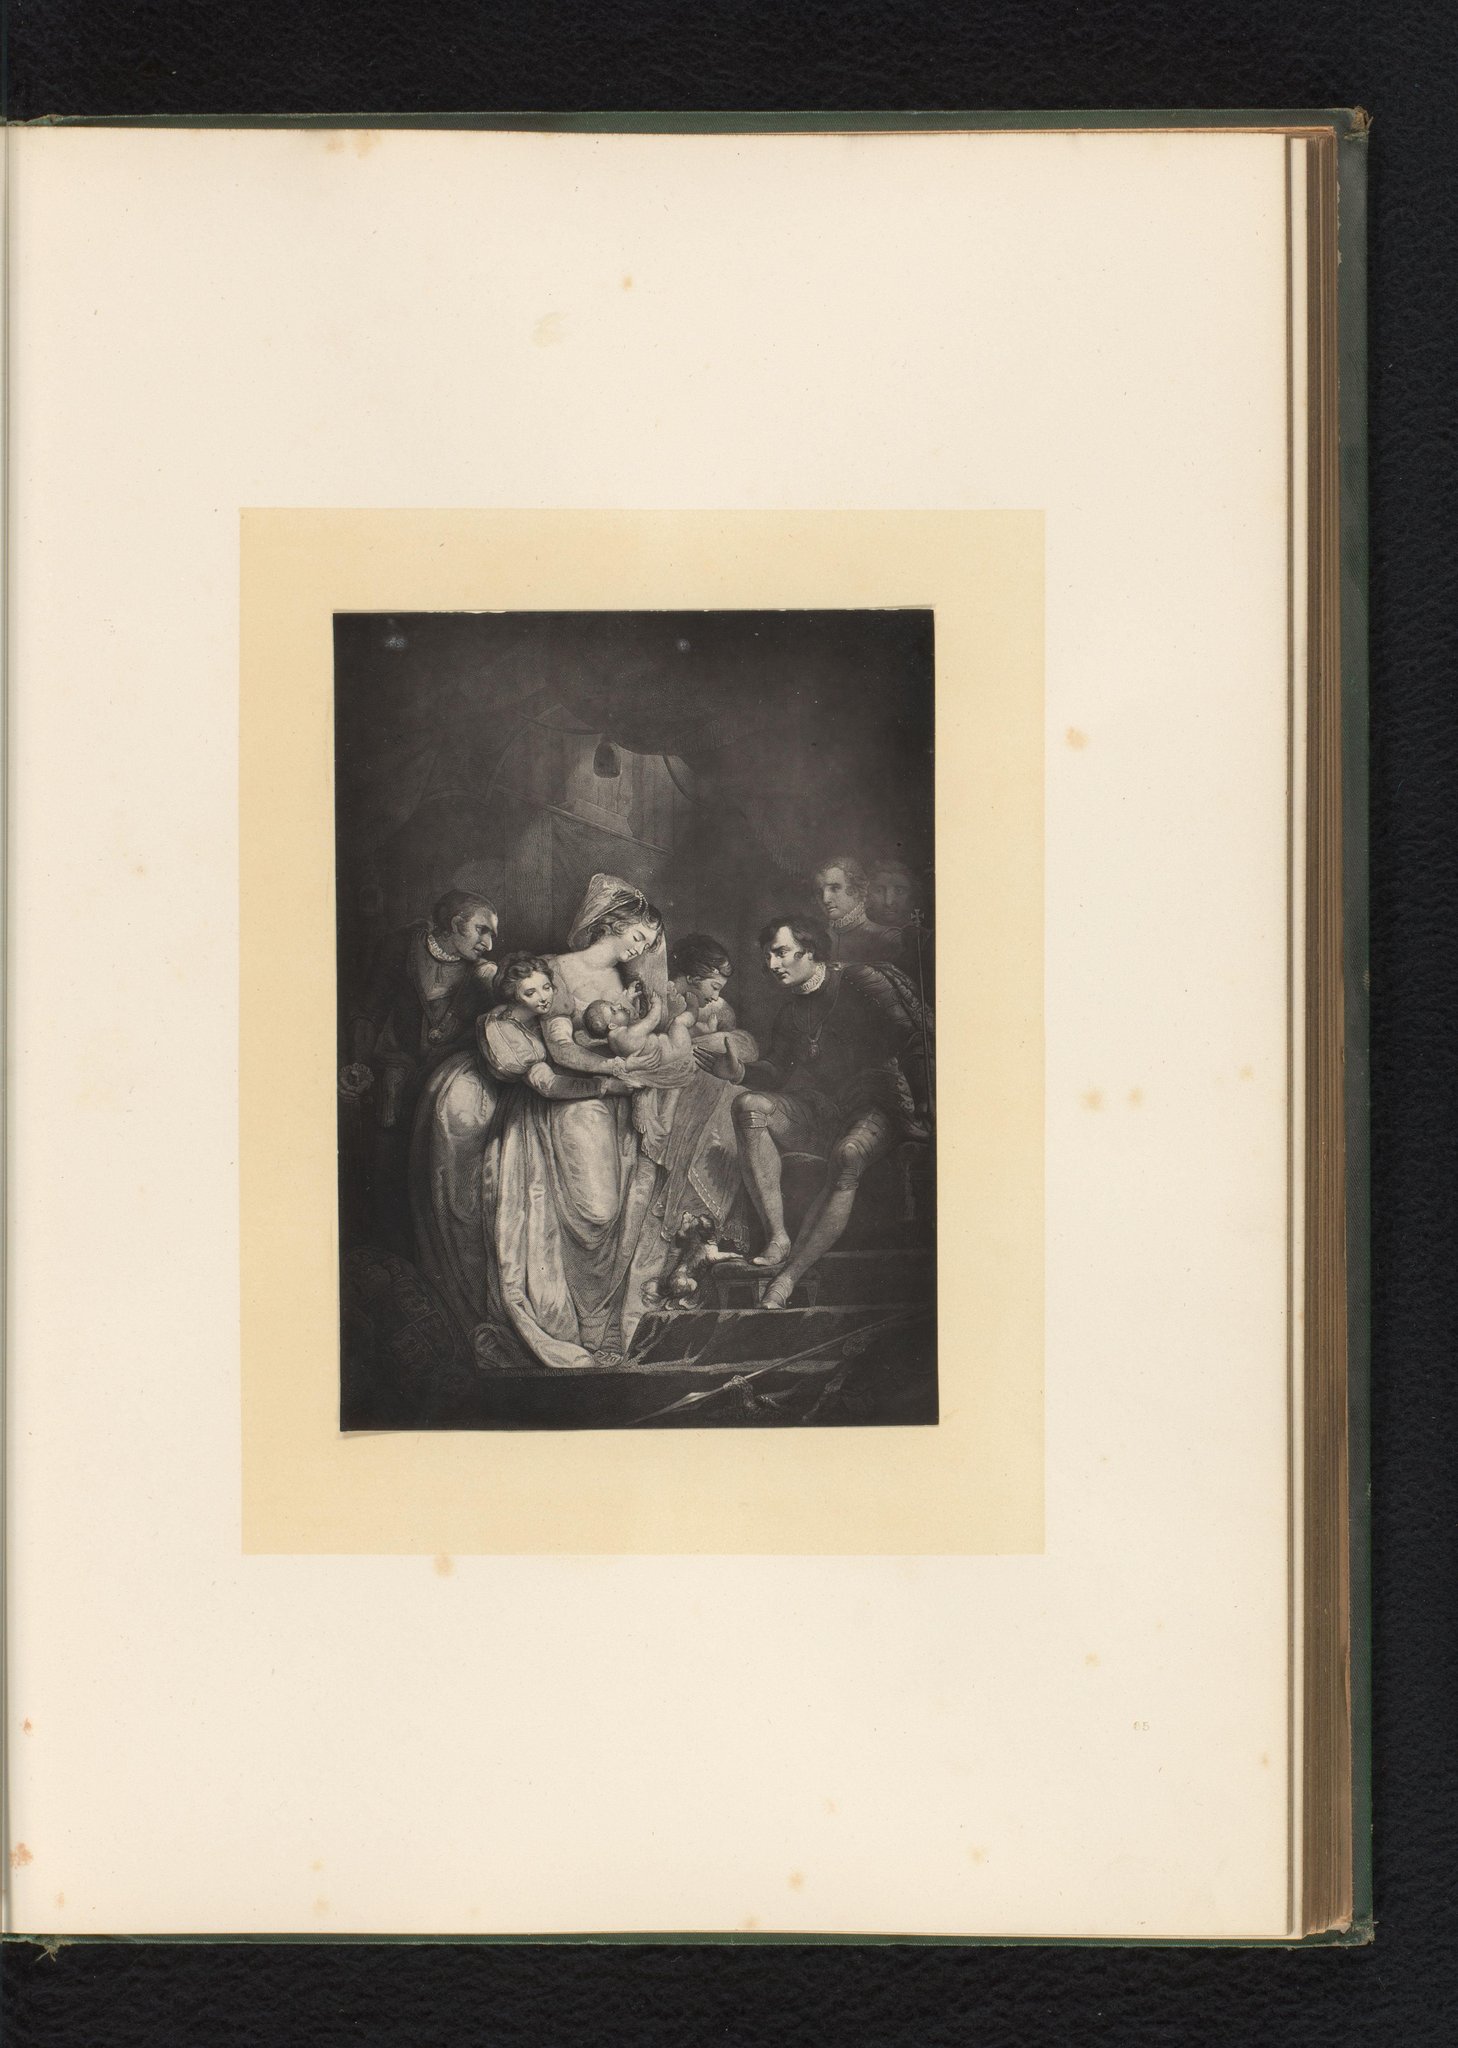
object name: page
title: Reproductie van een gravure naar een schilderij van een scène uit King Henry the Sixth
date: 1874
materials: paper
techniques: woodburytype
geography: london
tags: theatre, theatrical performance